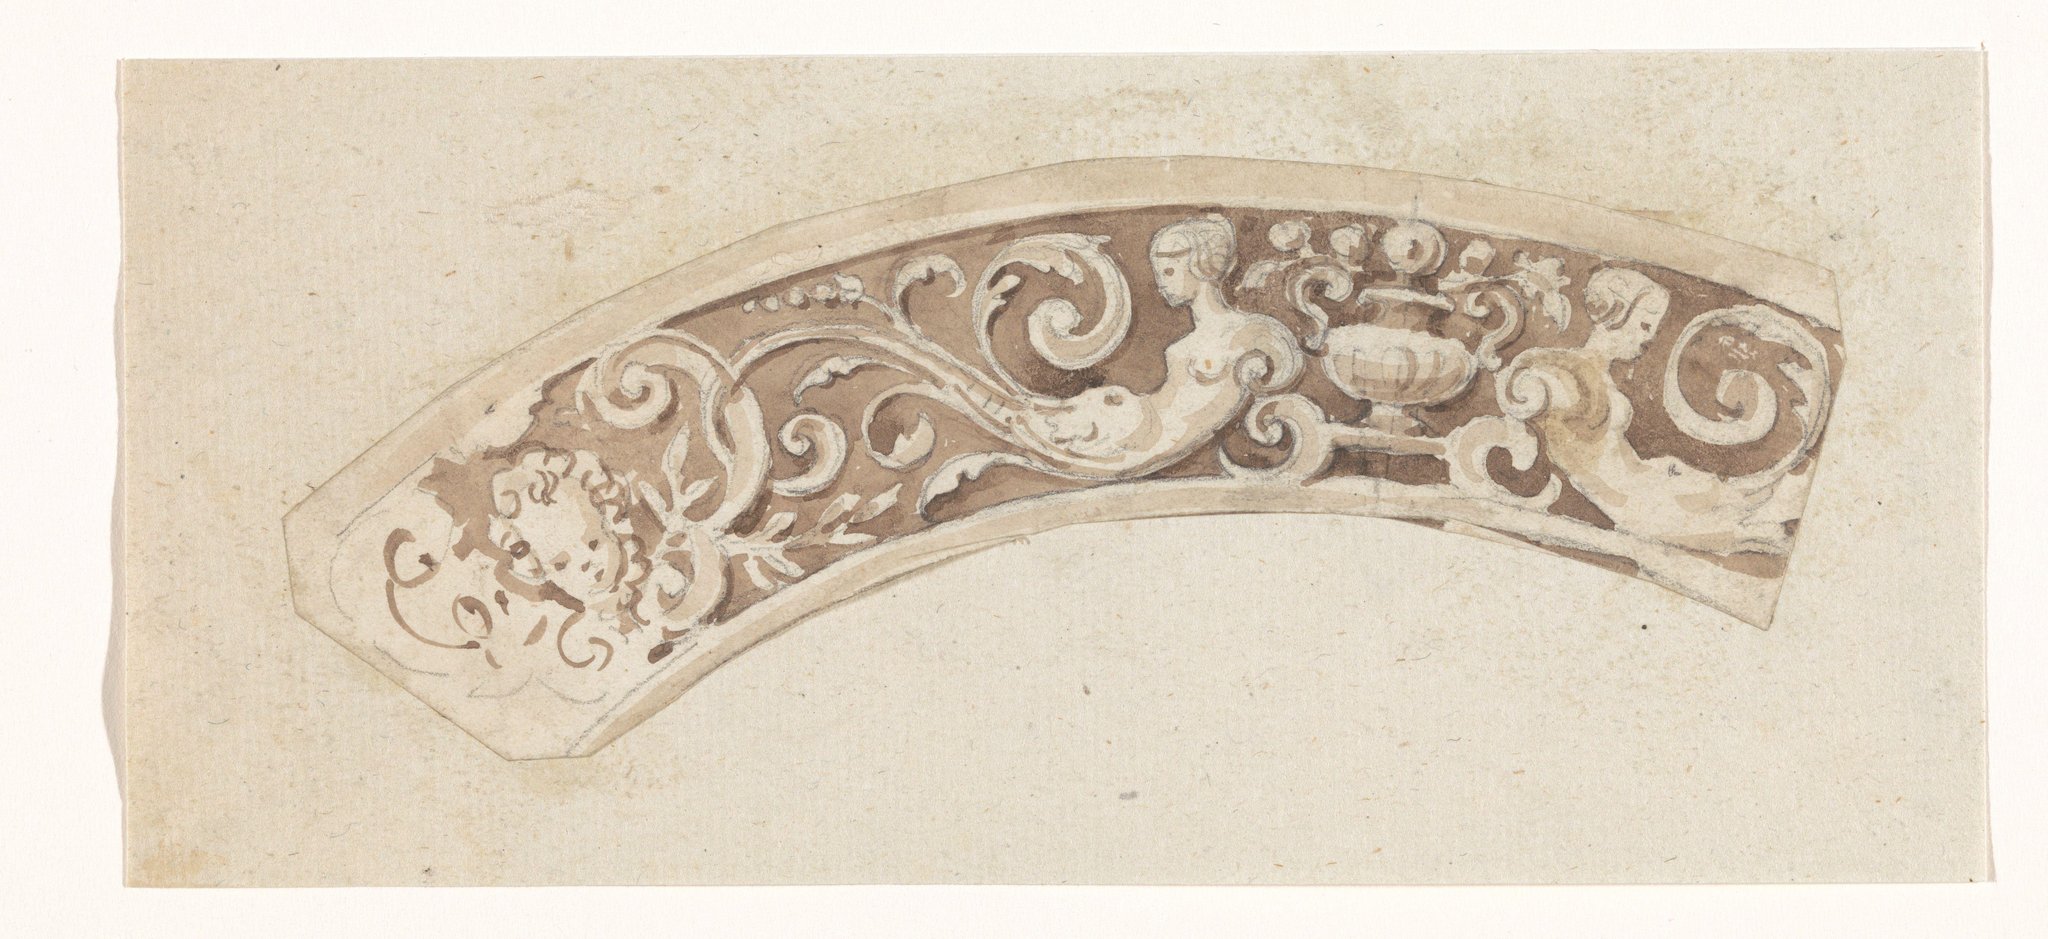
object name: design drawing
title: Deel van een schotelrand met ranken en figuren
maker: Anonymous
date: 1840-1860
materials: graphite, paper, watercolor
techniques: aquarelle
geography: france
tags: ornament derived from plant forms